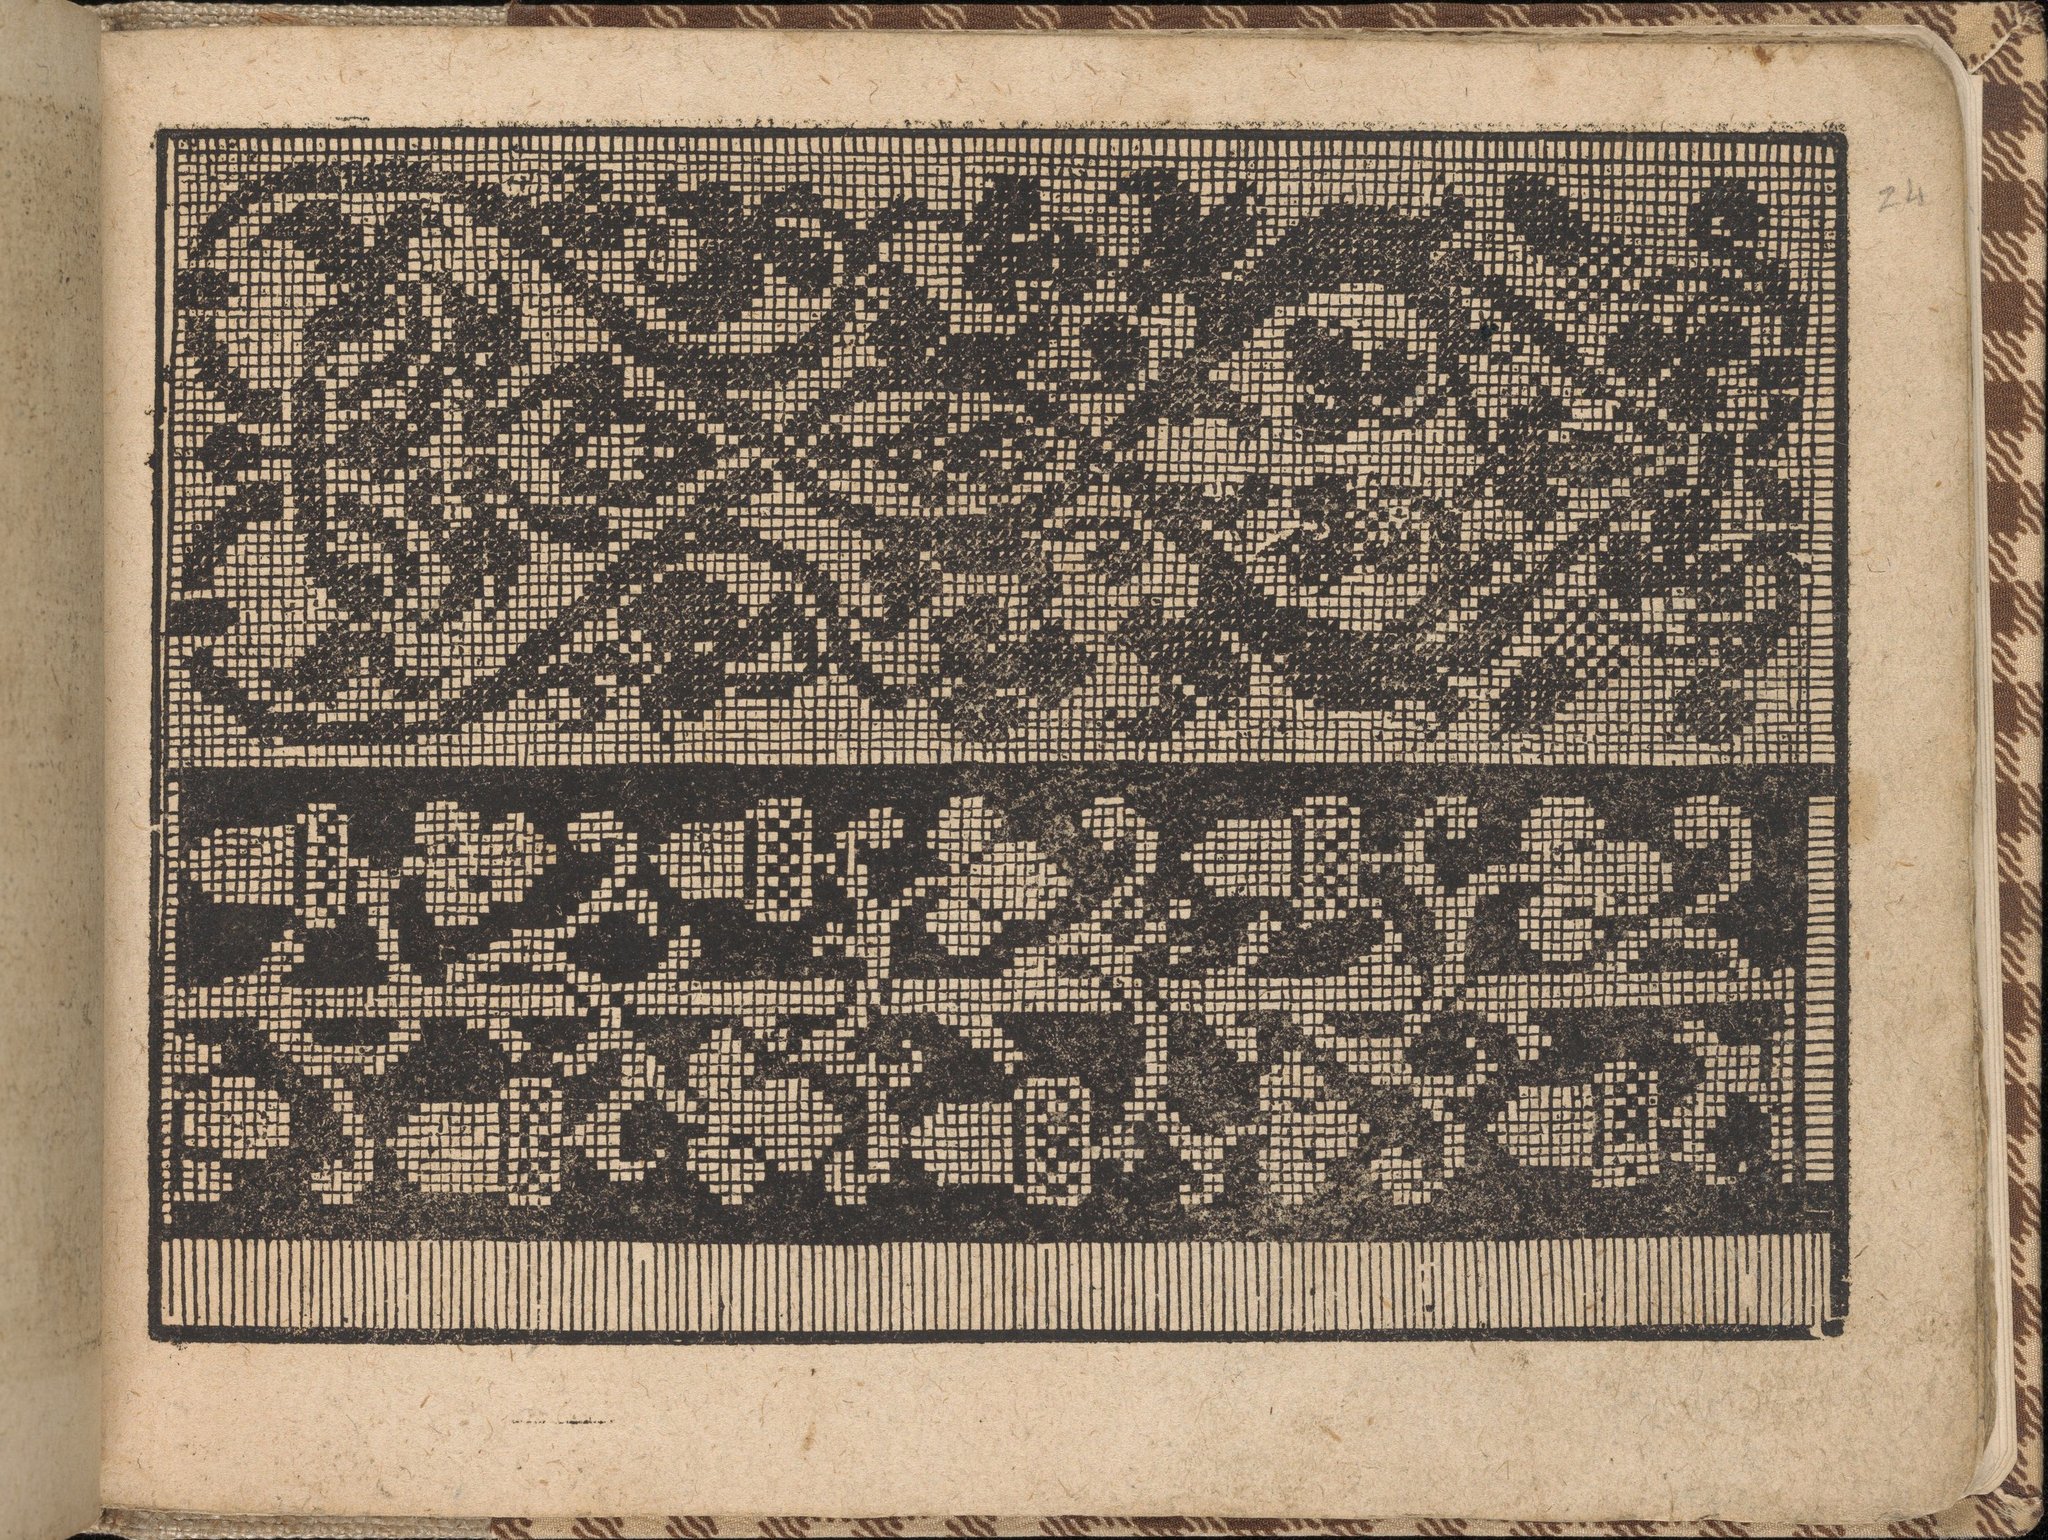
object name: book print ornament architecture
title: New Künstlichs Modelbuch (Page 24 recto)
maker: bernhard jobin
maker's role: publisher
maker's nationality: swiss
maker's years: 1535-1597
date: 1600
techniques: woodcut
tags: flowers